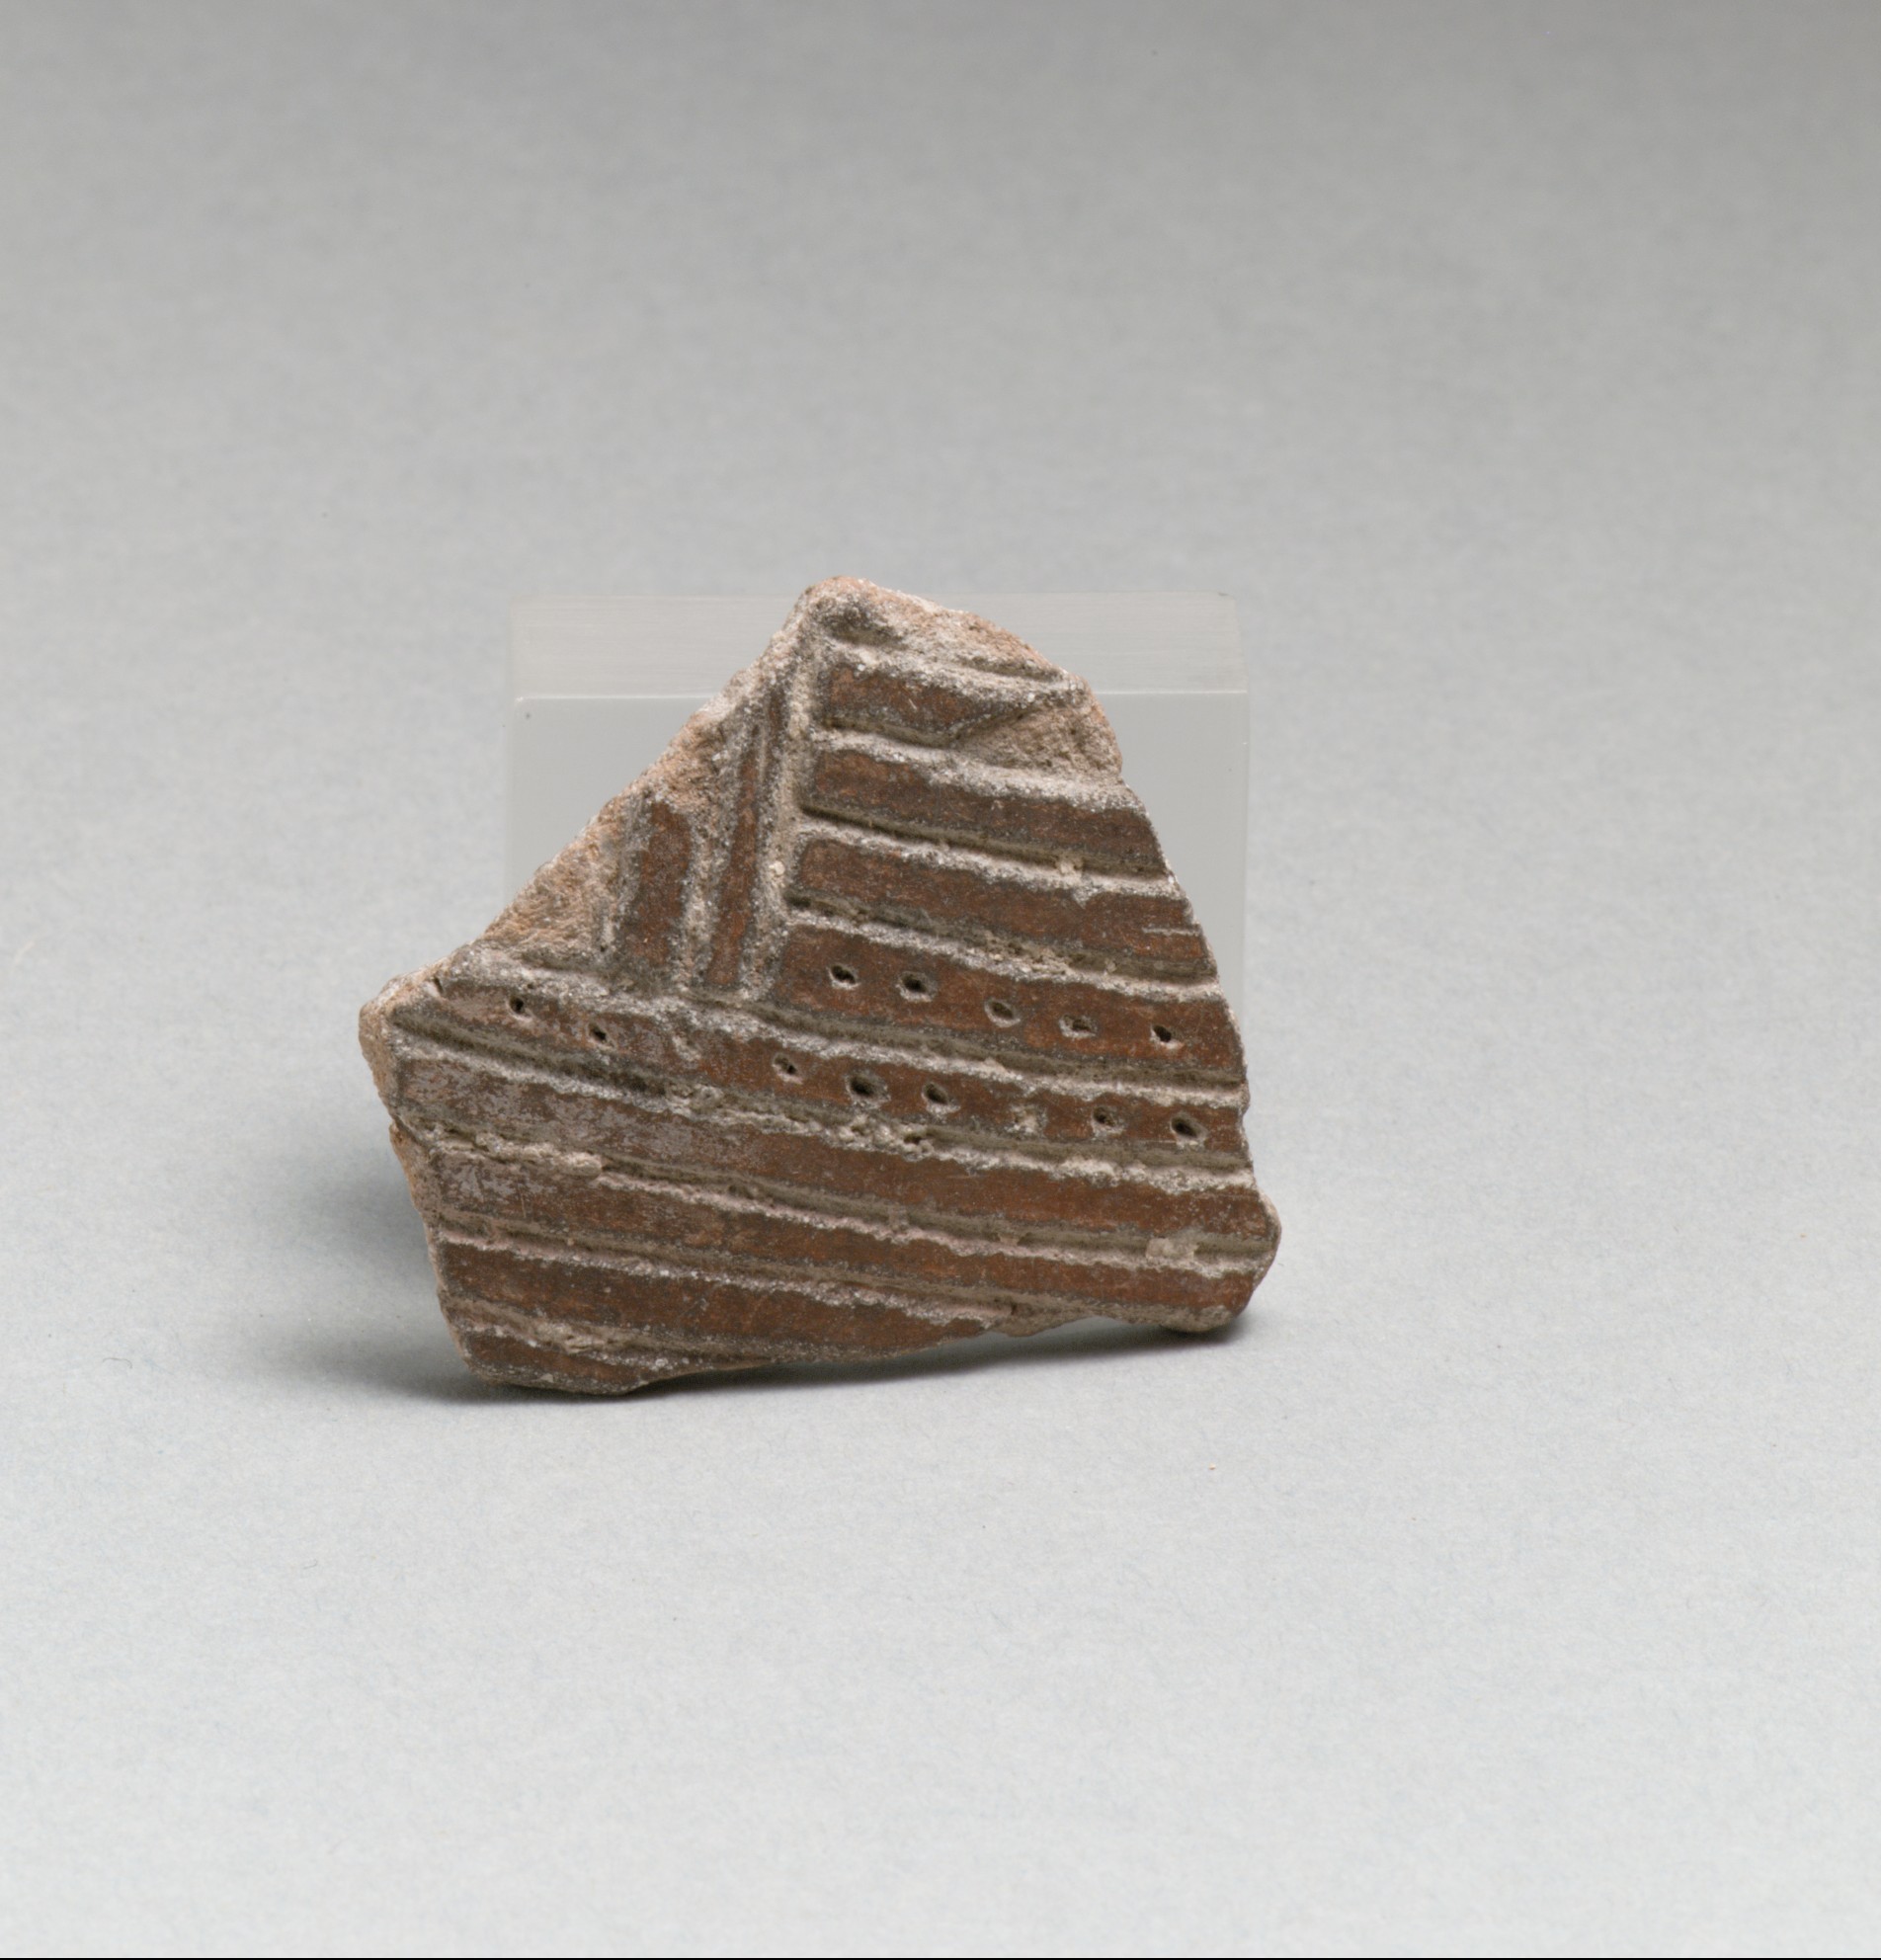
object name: vase fragment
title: Terracotta vessel fragment with incised lines and punctations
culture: cretan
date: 3600-3100 BCE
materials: terracotta